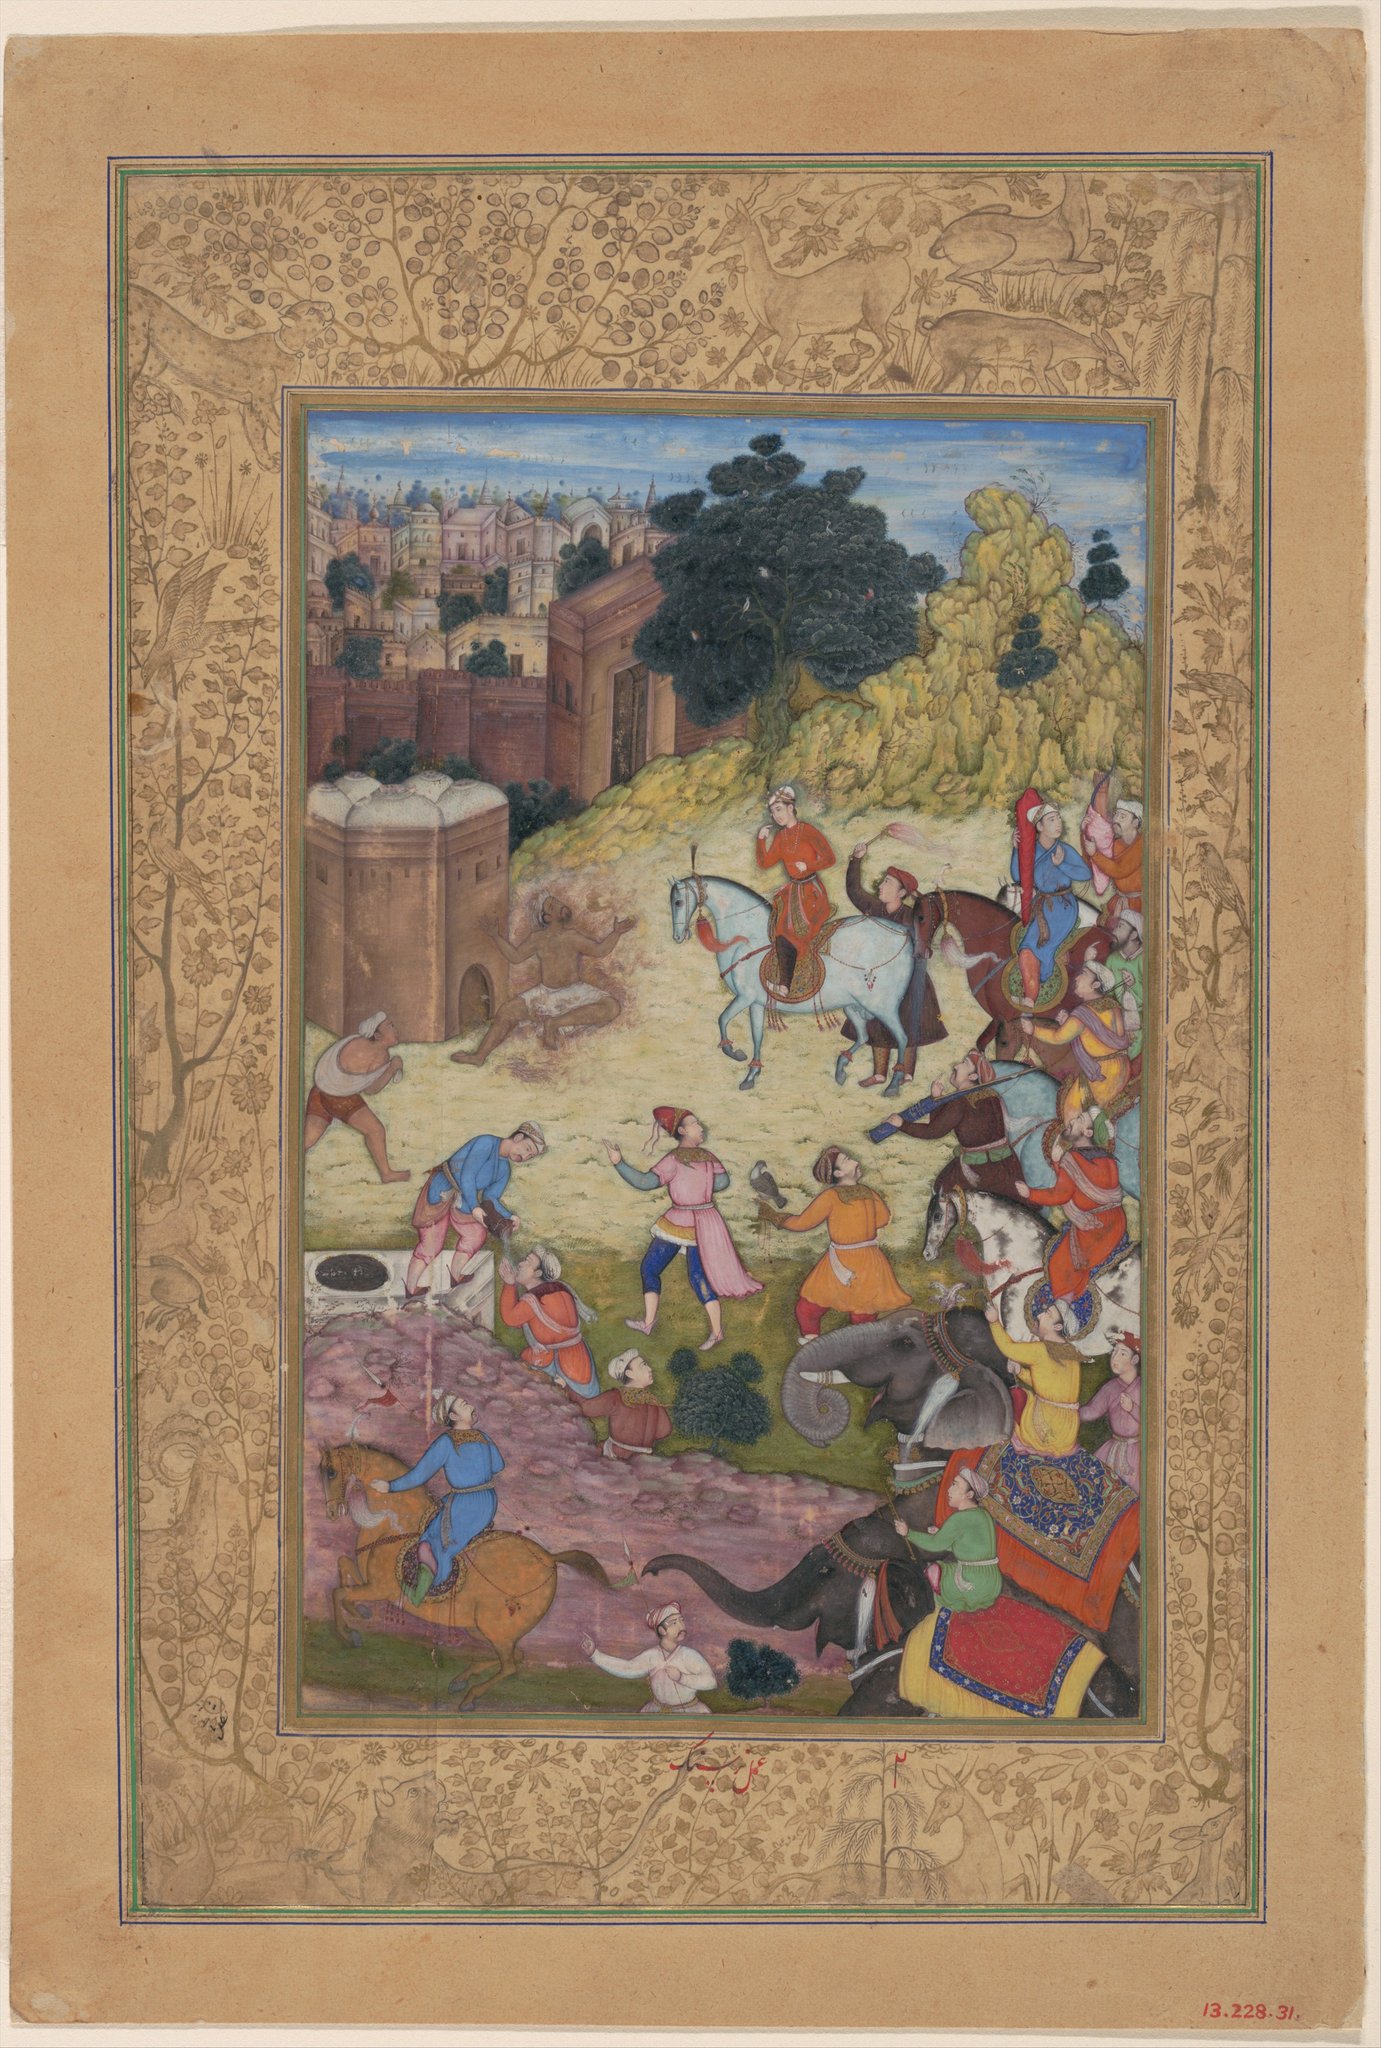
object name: folio from an illustrated manuscript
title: "A Bathhouse Keeper is Consumed by Passion for his Beloved", Folio from a Khamsa (Quintet) of Amir Khusrau Dihlavi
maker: amir khusrau dihlavi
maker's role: author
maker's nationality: indian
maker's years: 1228-1350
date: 1597-1598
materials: gold, ink, paper, watercolor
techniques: dyeing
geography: pakistan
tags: poetry,men,elephants,horses